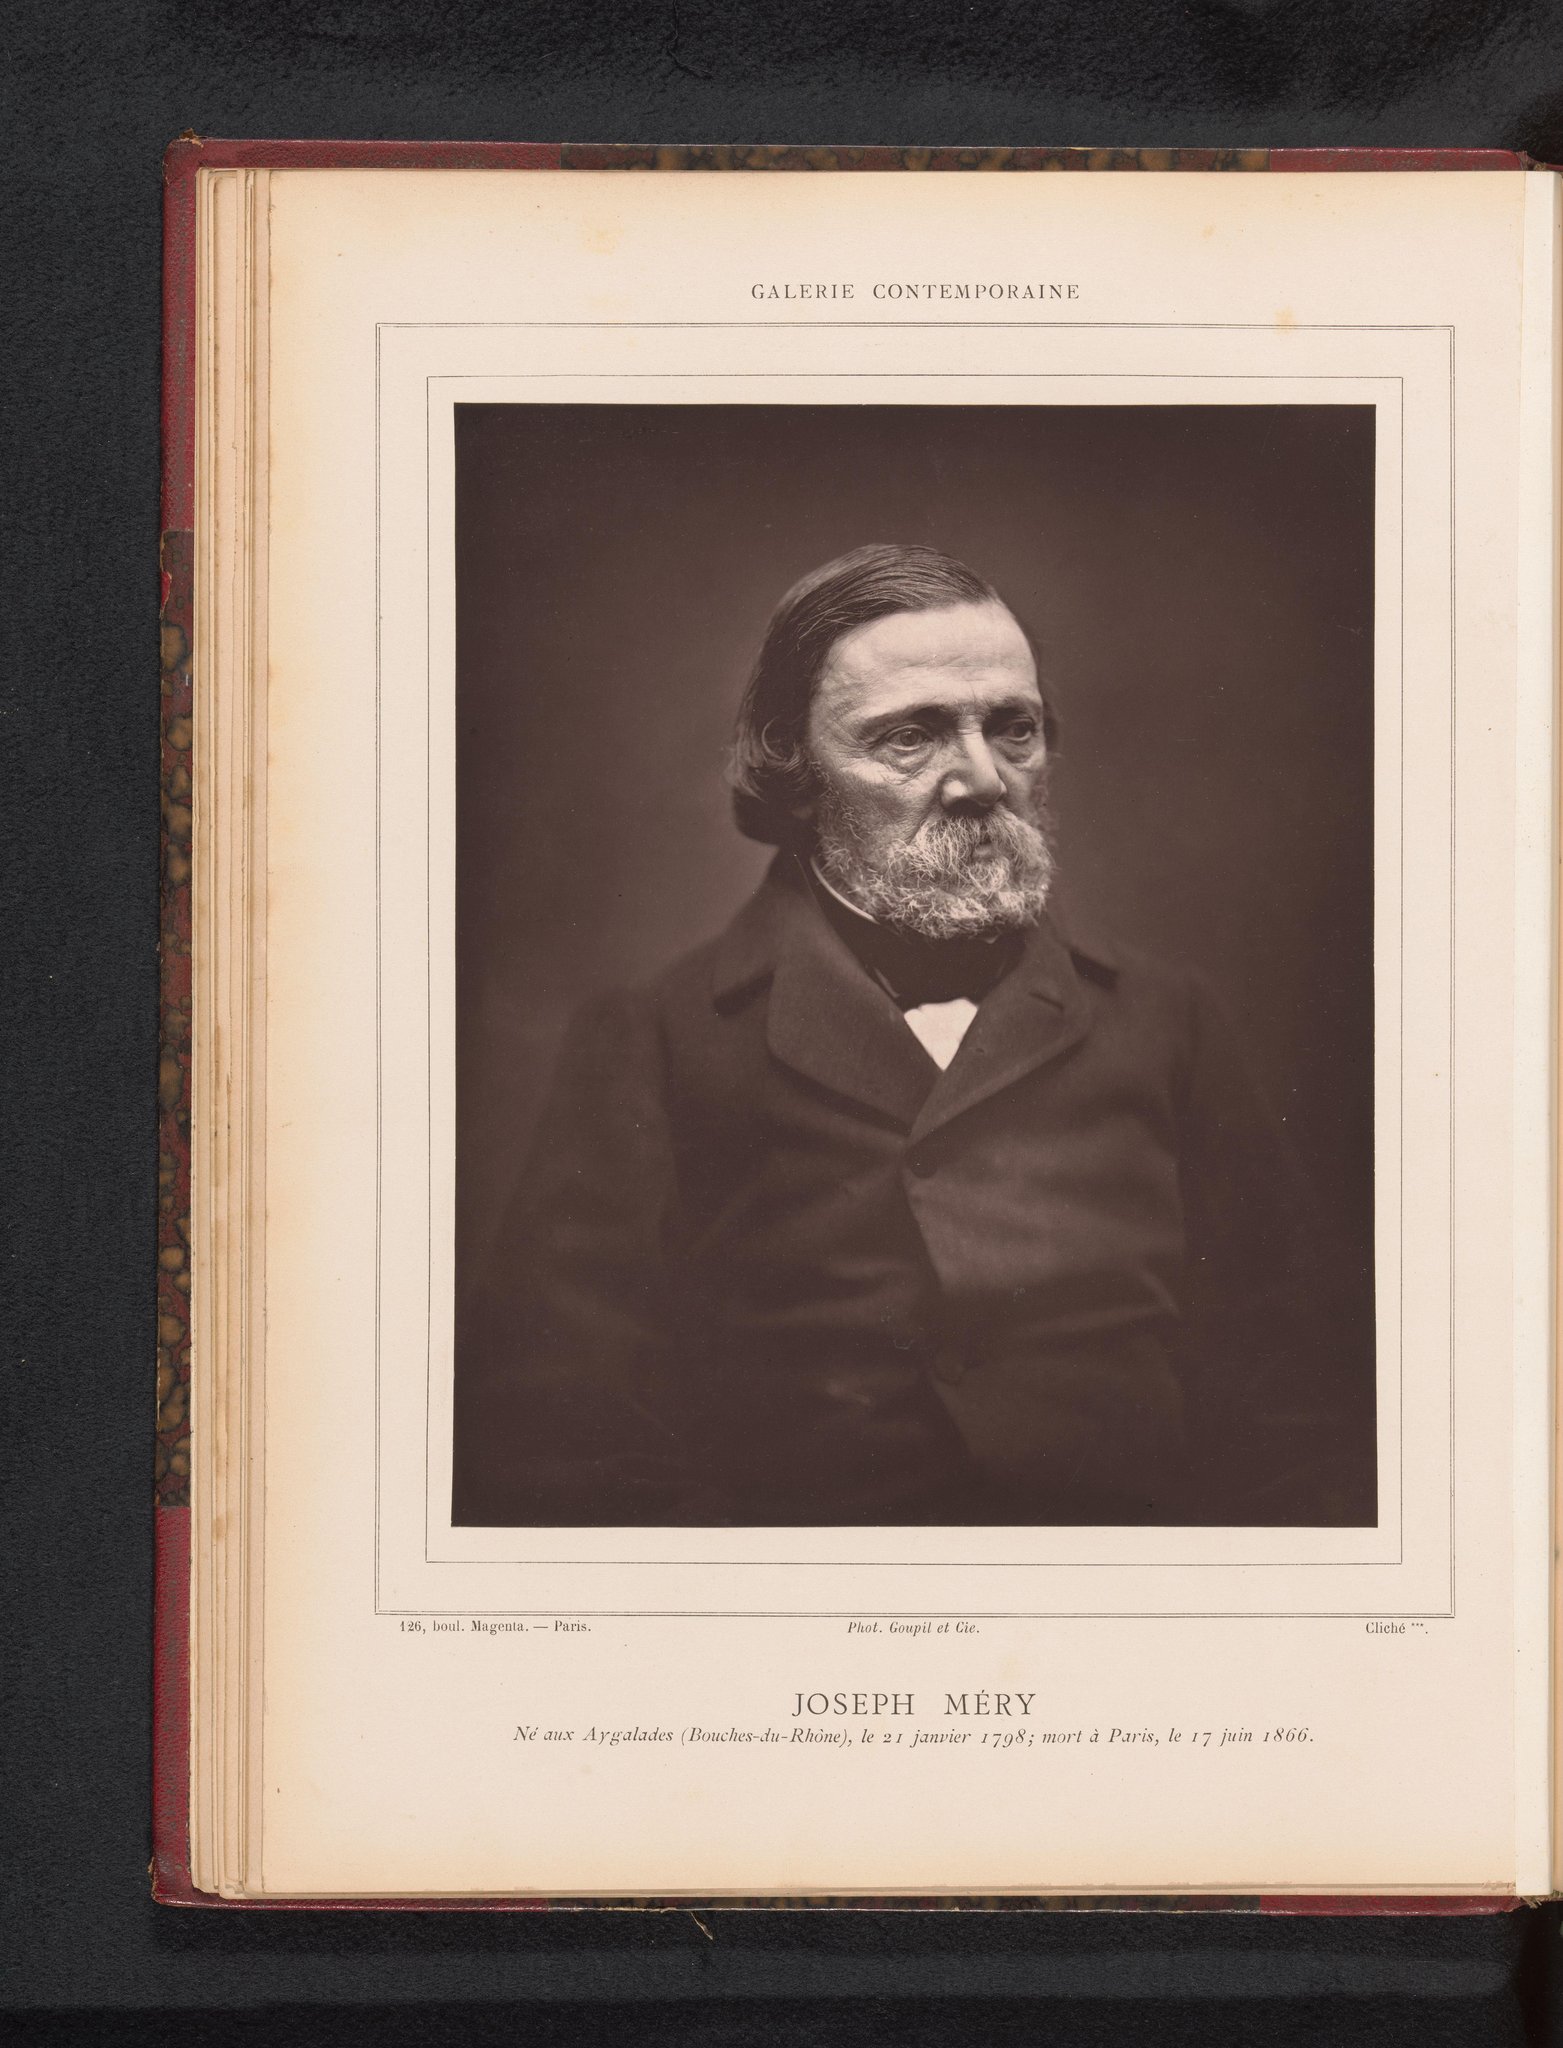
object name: page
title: Joseph Méry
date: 1866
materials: paper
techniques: woodburytype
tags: adult man, historical persons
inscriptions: inscription: ‘Galerie Contemporaine/ 126, boul. Magenta. - Paris./ Né aux Aygalades (Bouches-du-Rhône), le 21 janvier 1798; mort a Paris, le 17 juin 1866.’